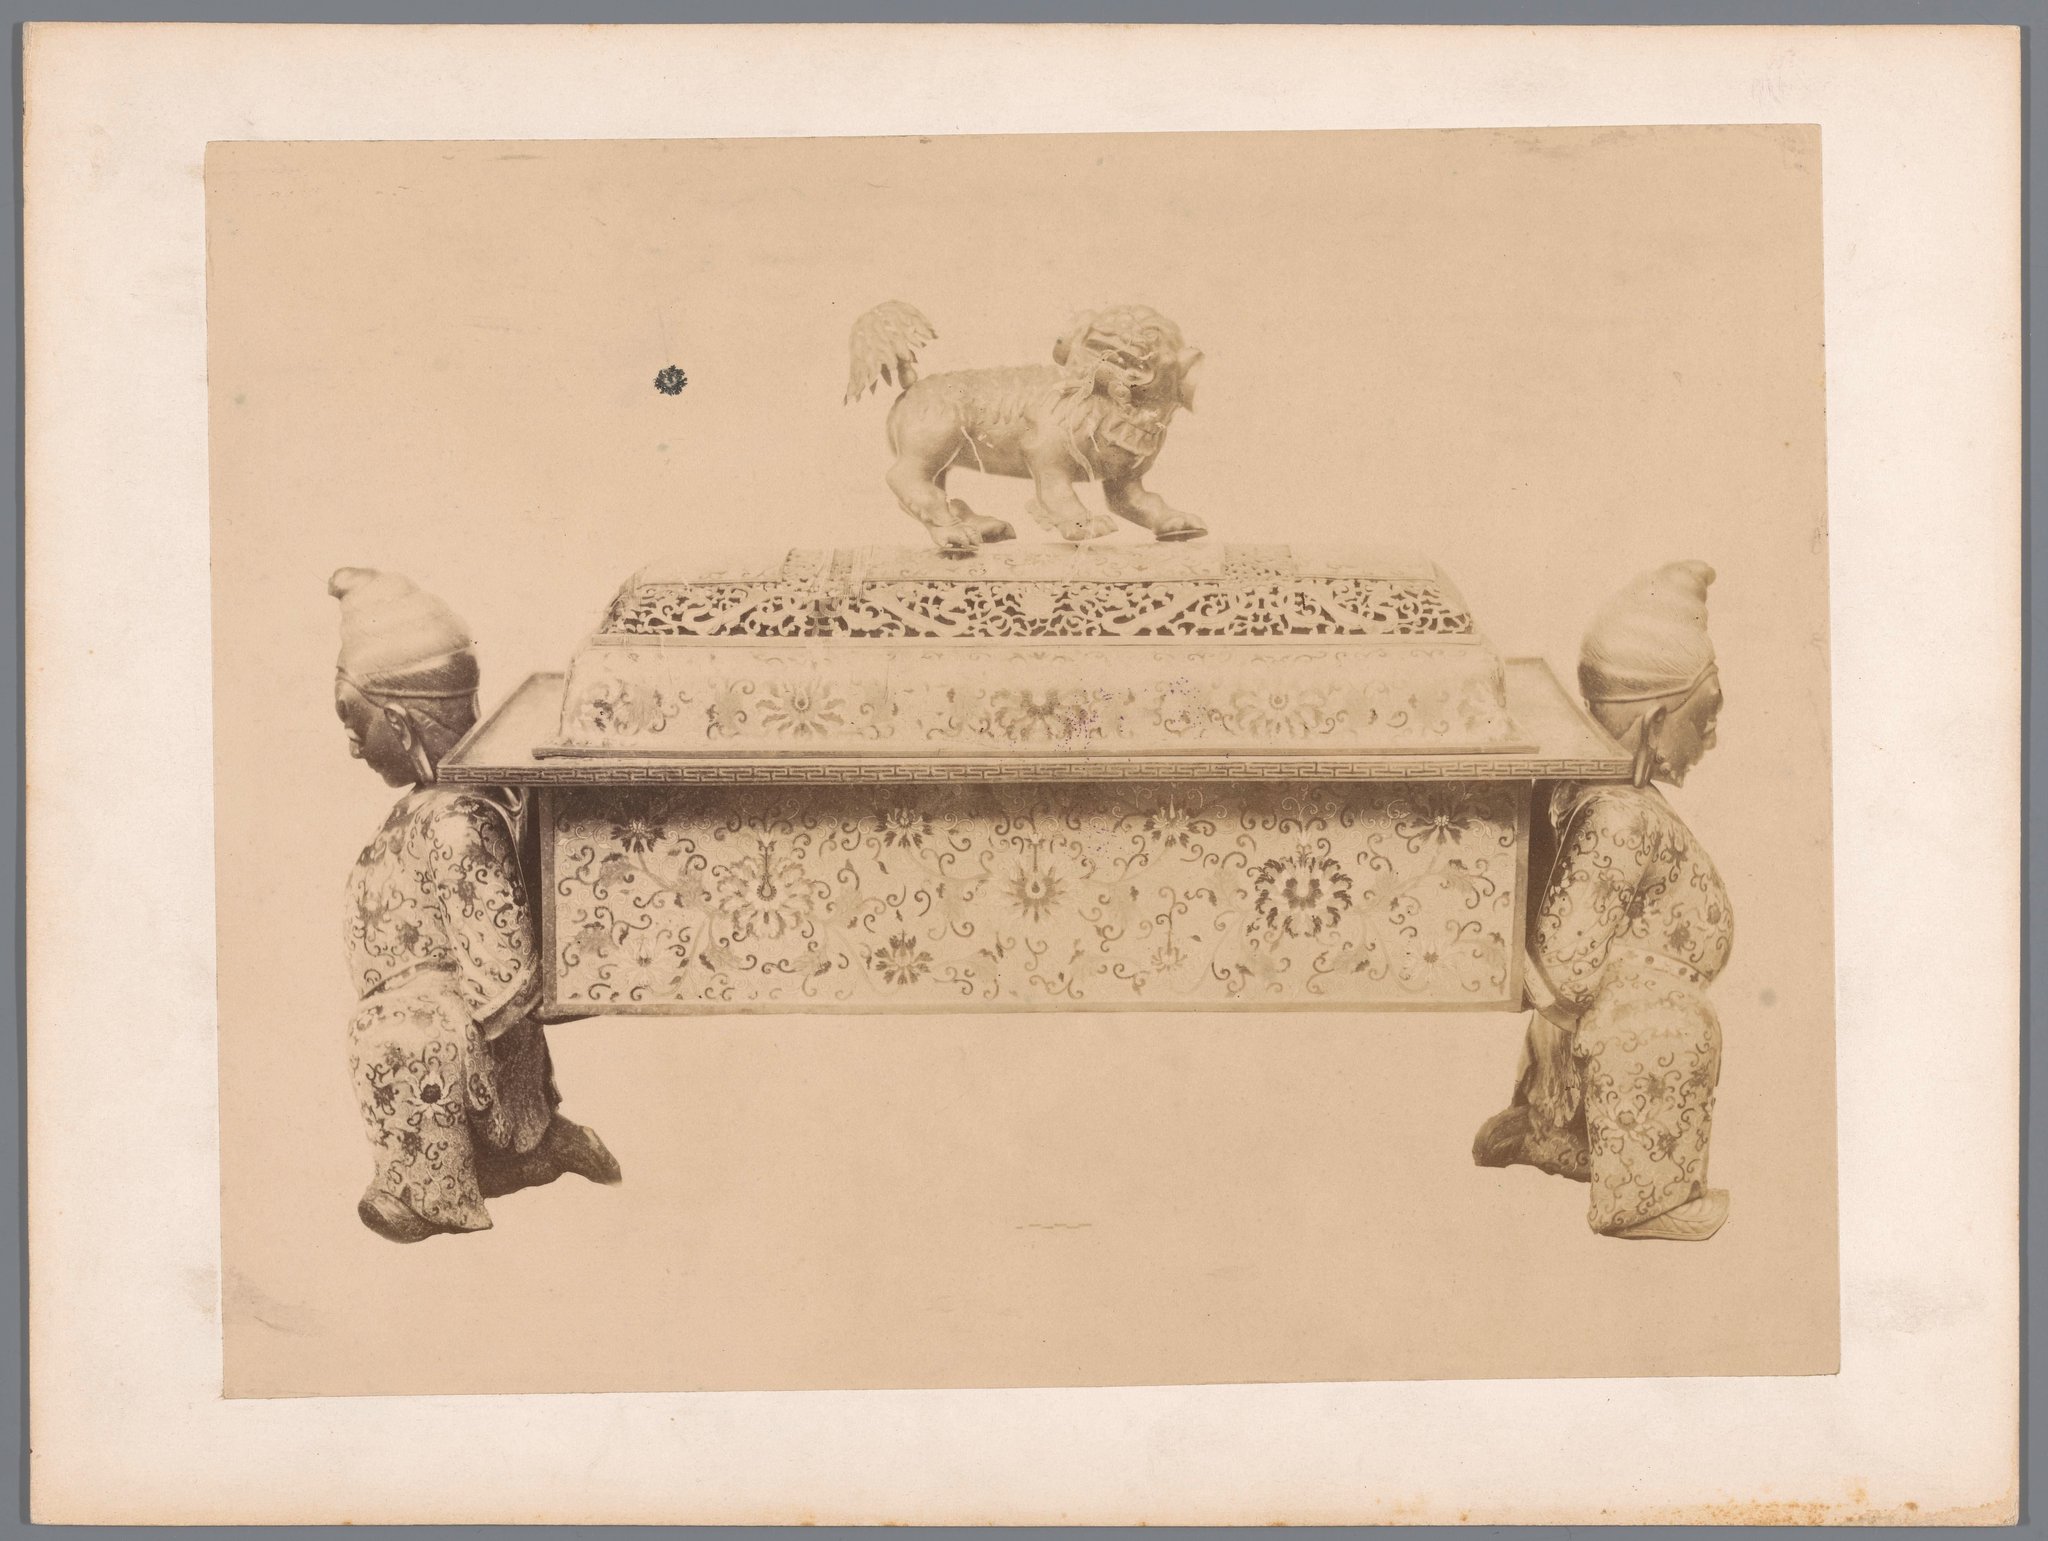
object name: photograph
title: Kist gedecoreerd met Aziatische motieven en als poten twee dragende mannen en een opengewerkte deksel met daarop een leeuw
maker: Anonymous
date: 1875-1900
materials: cardboard, photographic support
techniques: albumen print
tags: asiatic races and peoples, chest, coffer, beasts of prey, predatory animals: lion, flowers ~ ornament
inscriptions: collector's mark: Lugt 3937